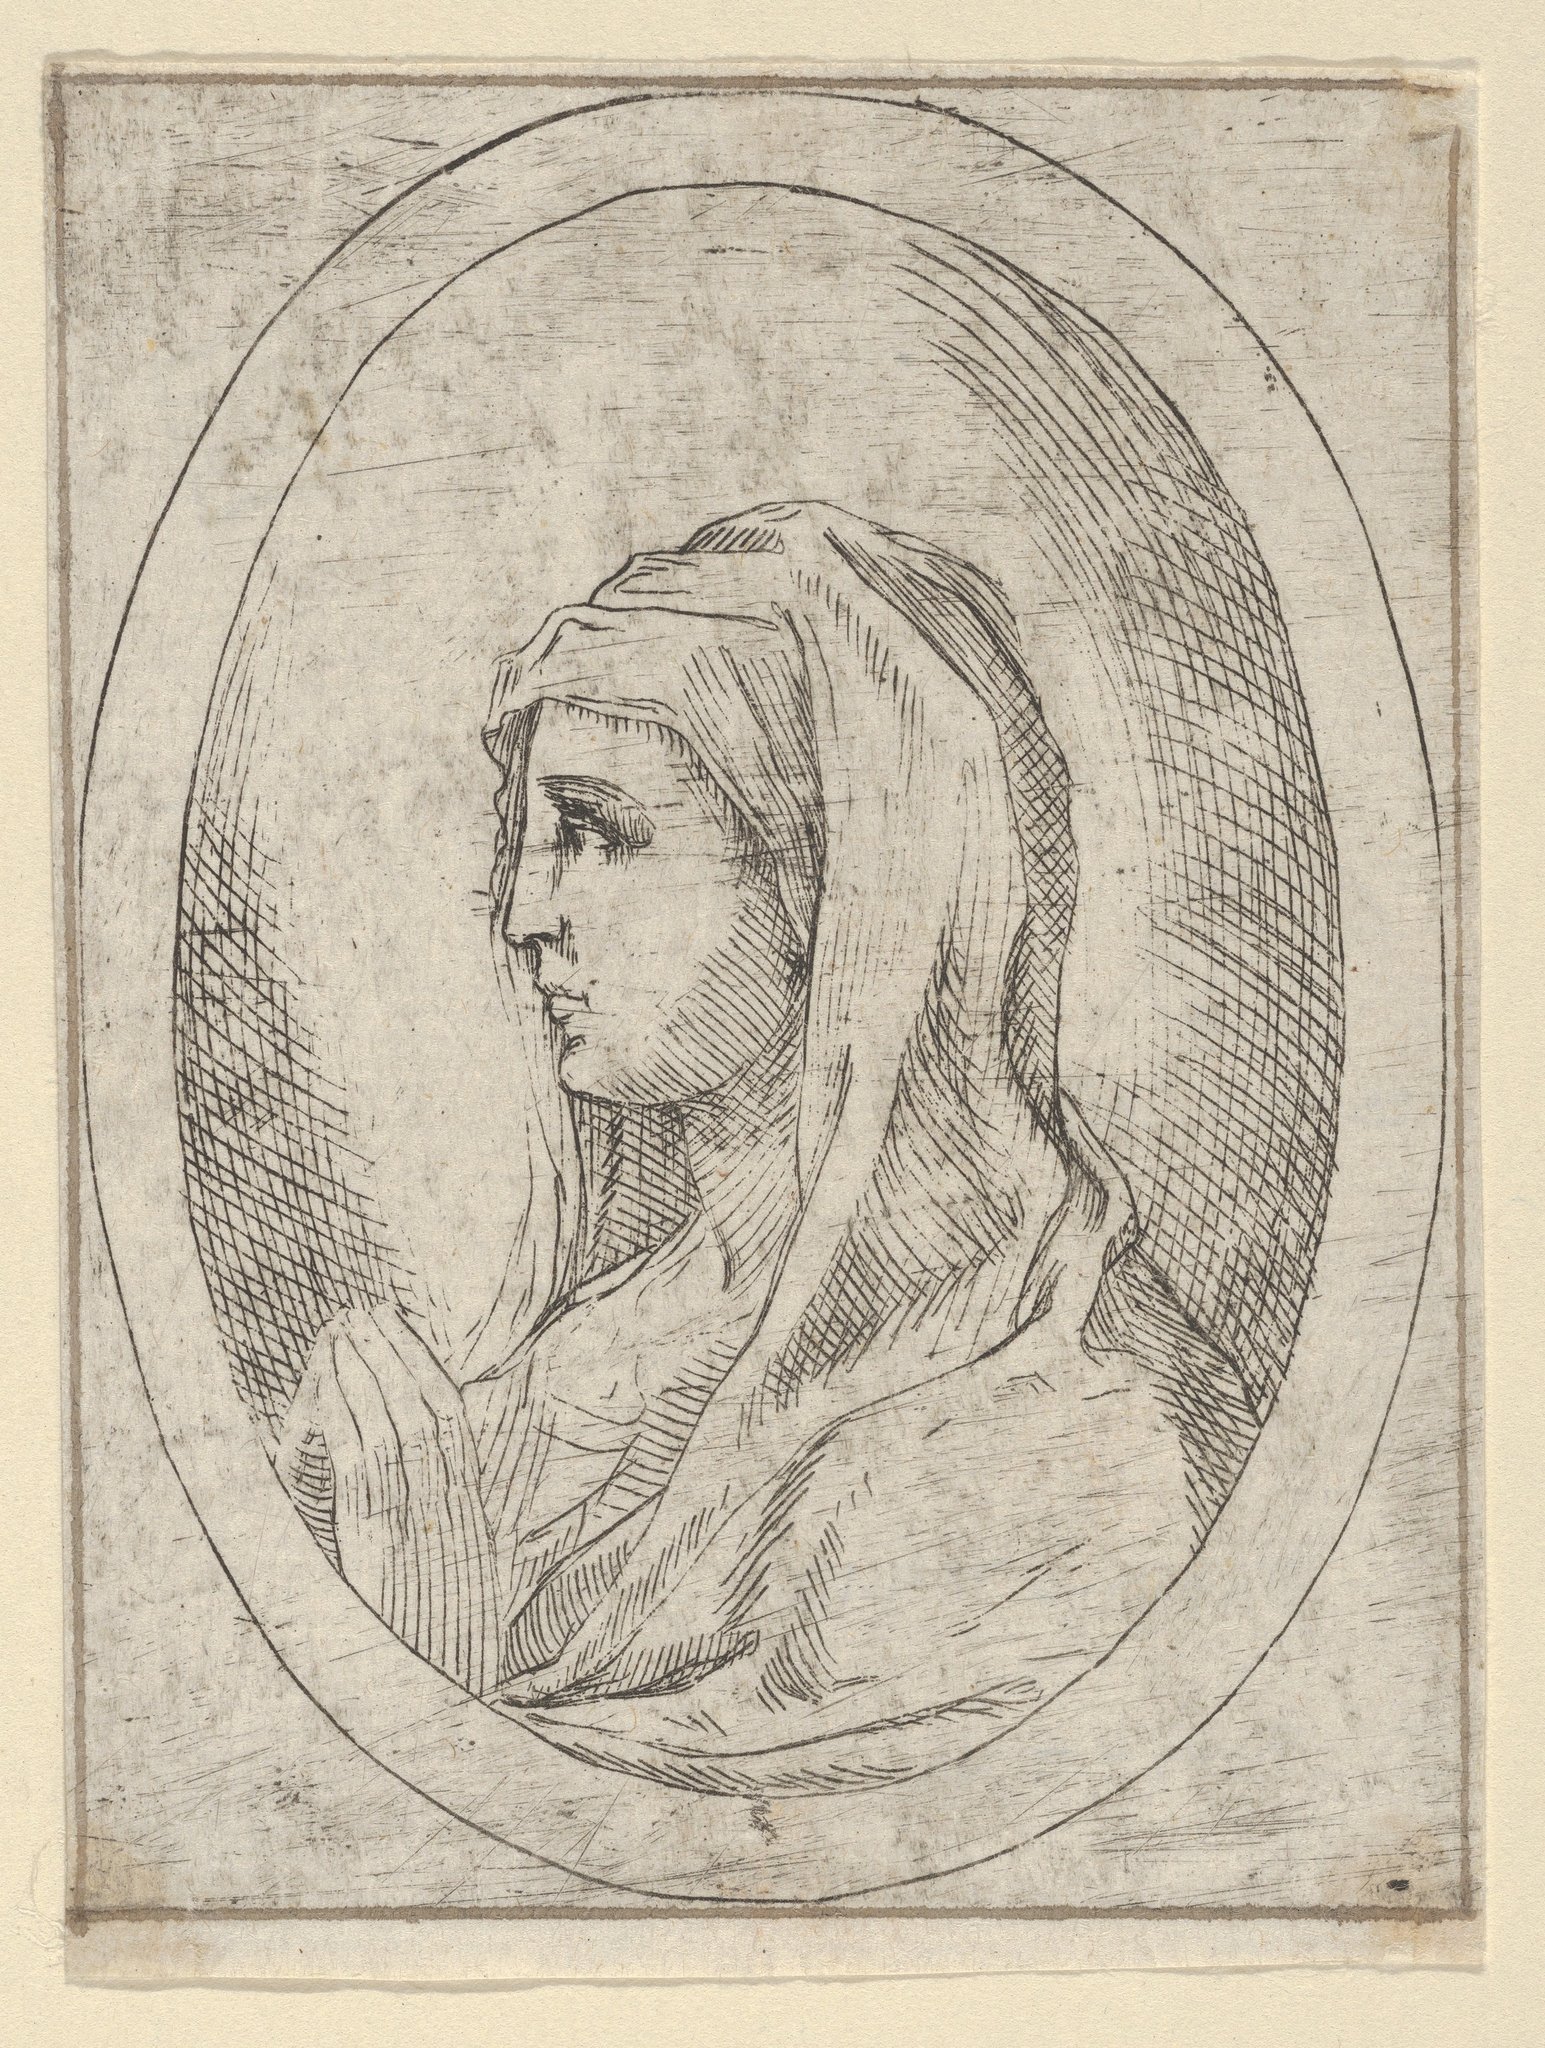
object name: print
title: The Virgin in prayer, seen in profile facing left, in an oval frame, from "Christ, the Virgin, and Thirteen Apostles"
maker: anonymous, 17th century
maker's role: artist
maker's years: 1600-1700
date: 1600-1640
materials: ink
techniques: etching, pen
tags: profiles,virgin mary